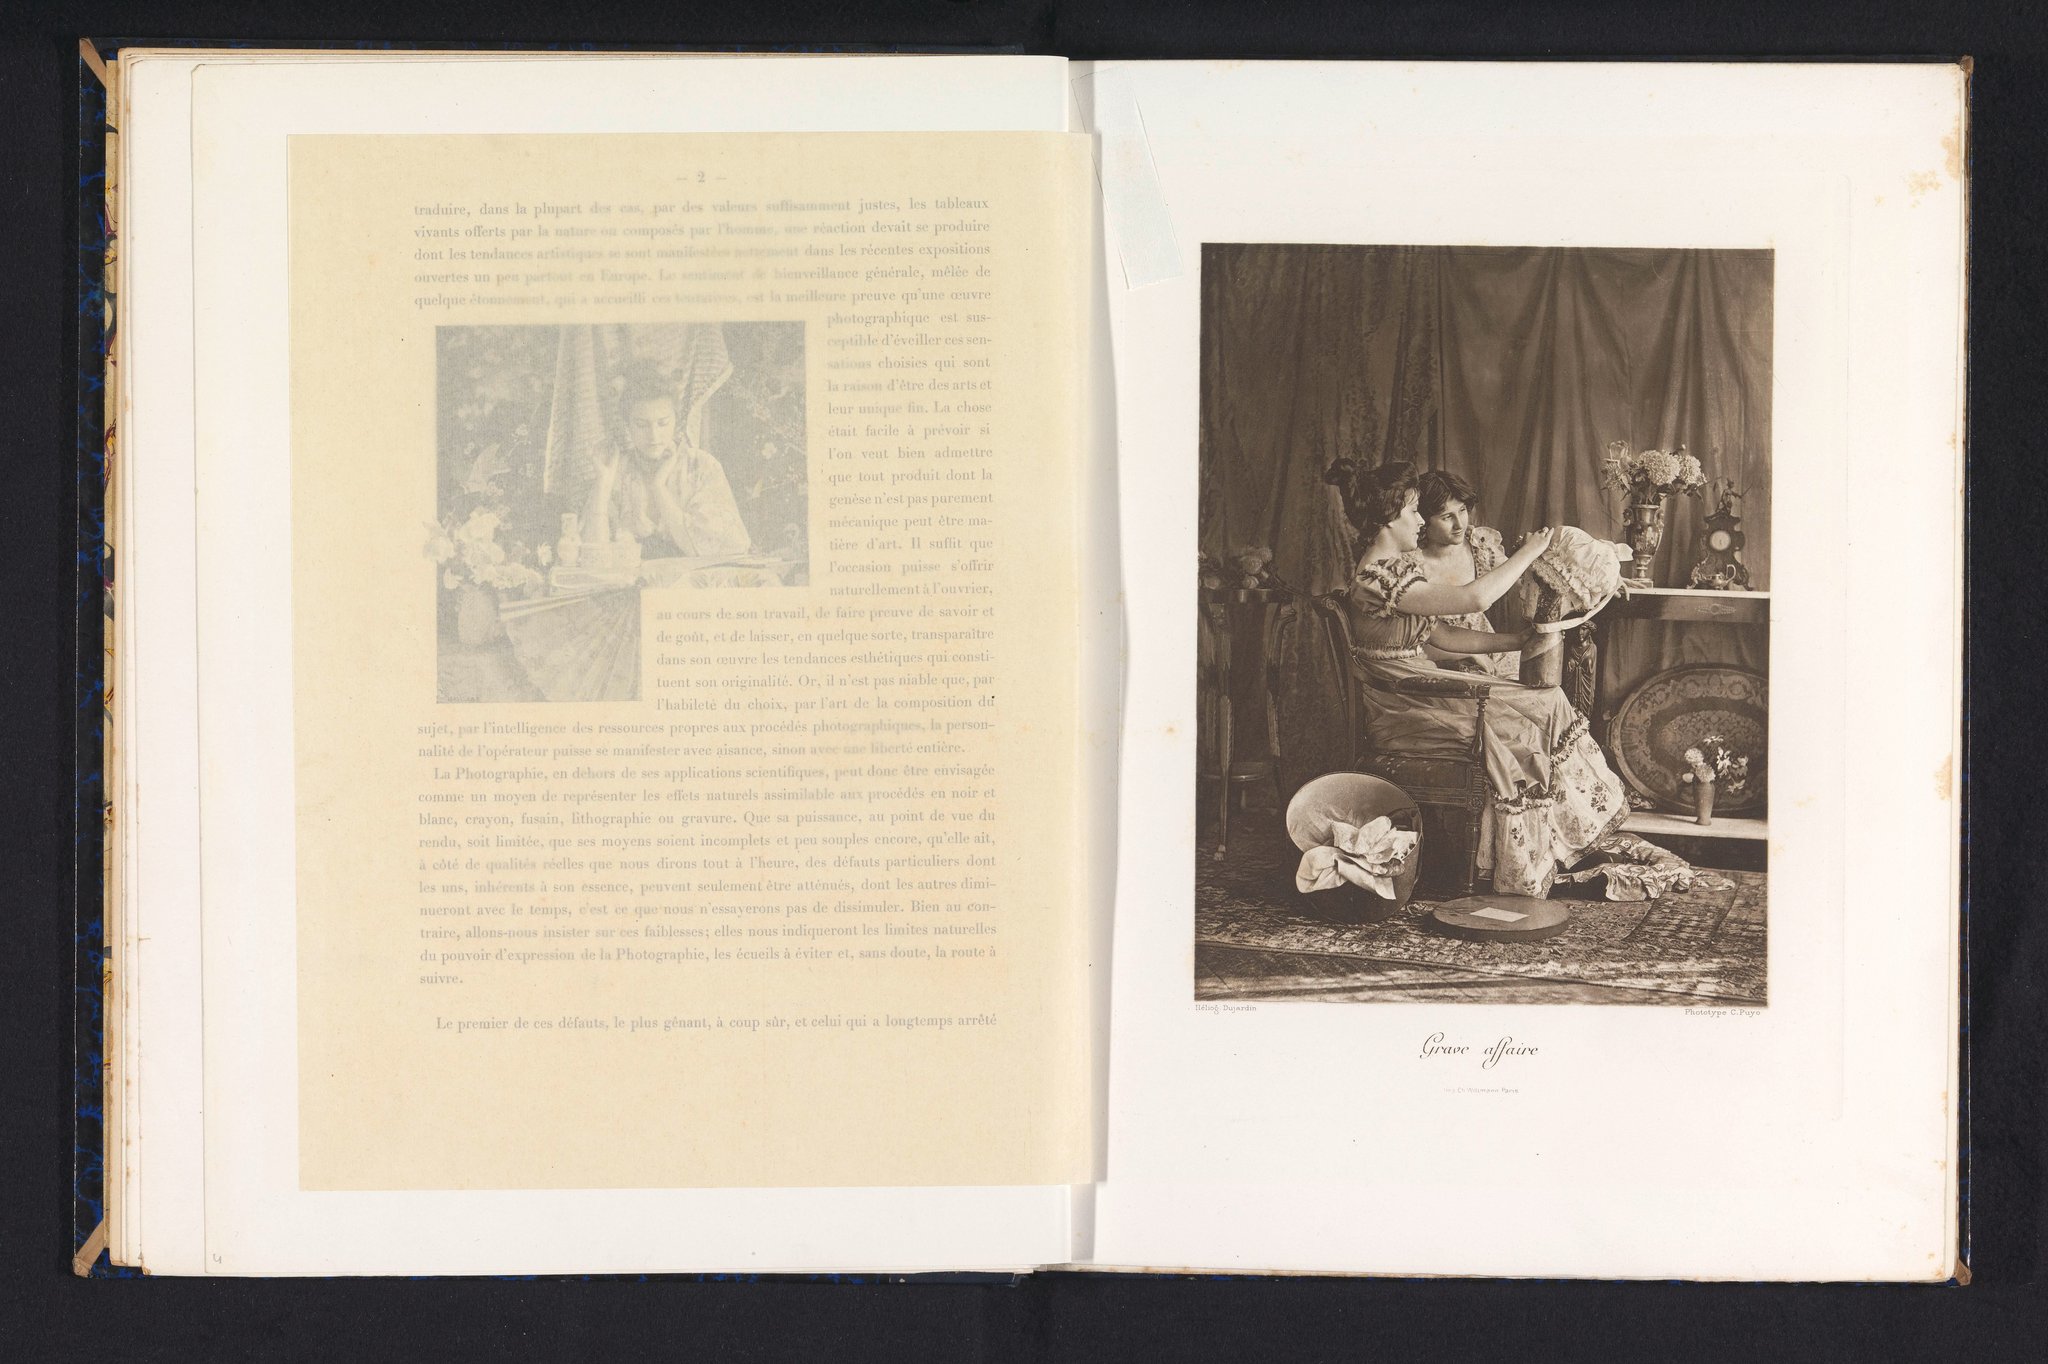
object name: photomechanical print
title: Twee vrouwen bekijken een hoed in een interieur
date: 1886-1896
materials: paper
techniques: photoaquatint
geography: france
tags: adult woman, fan, interior ~ representation of a building